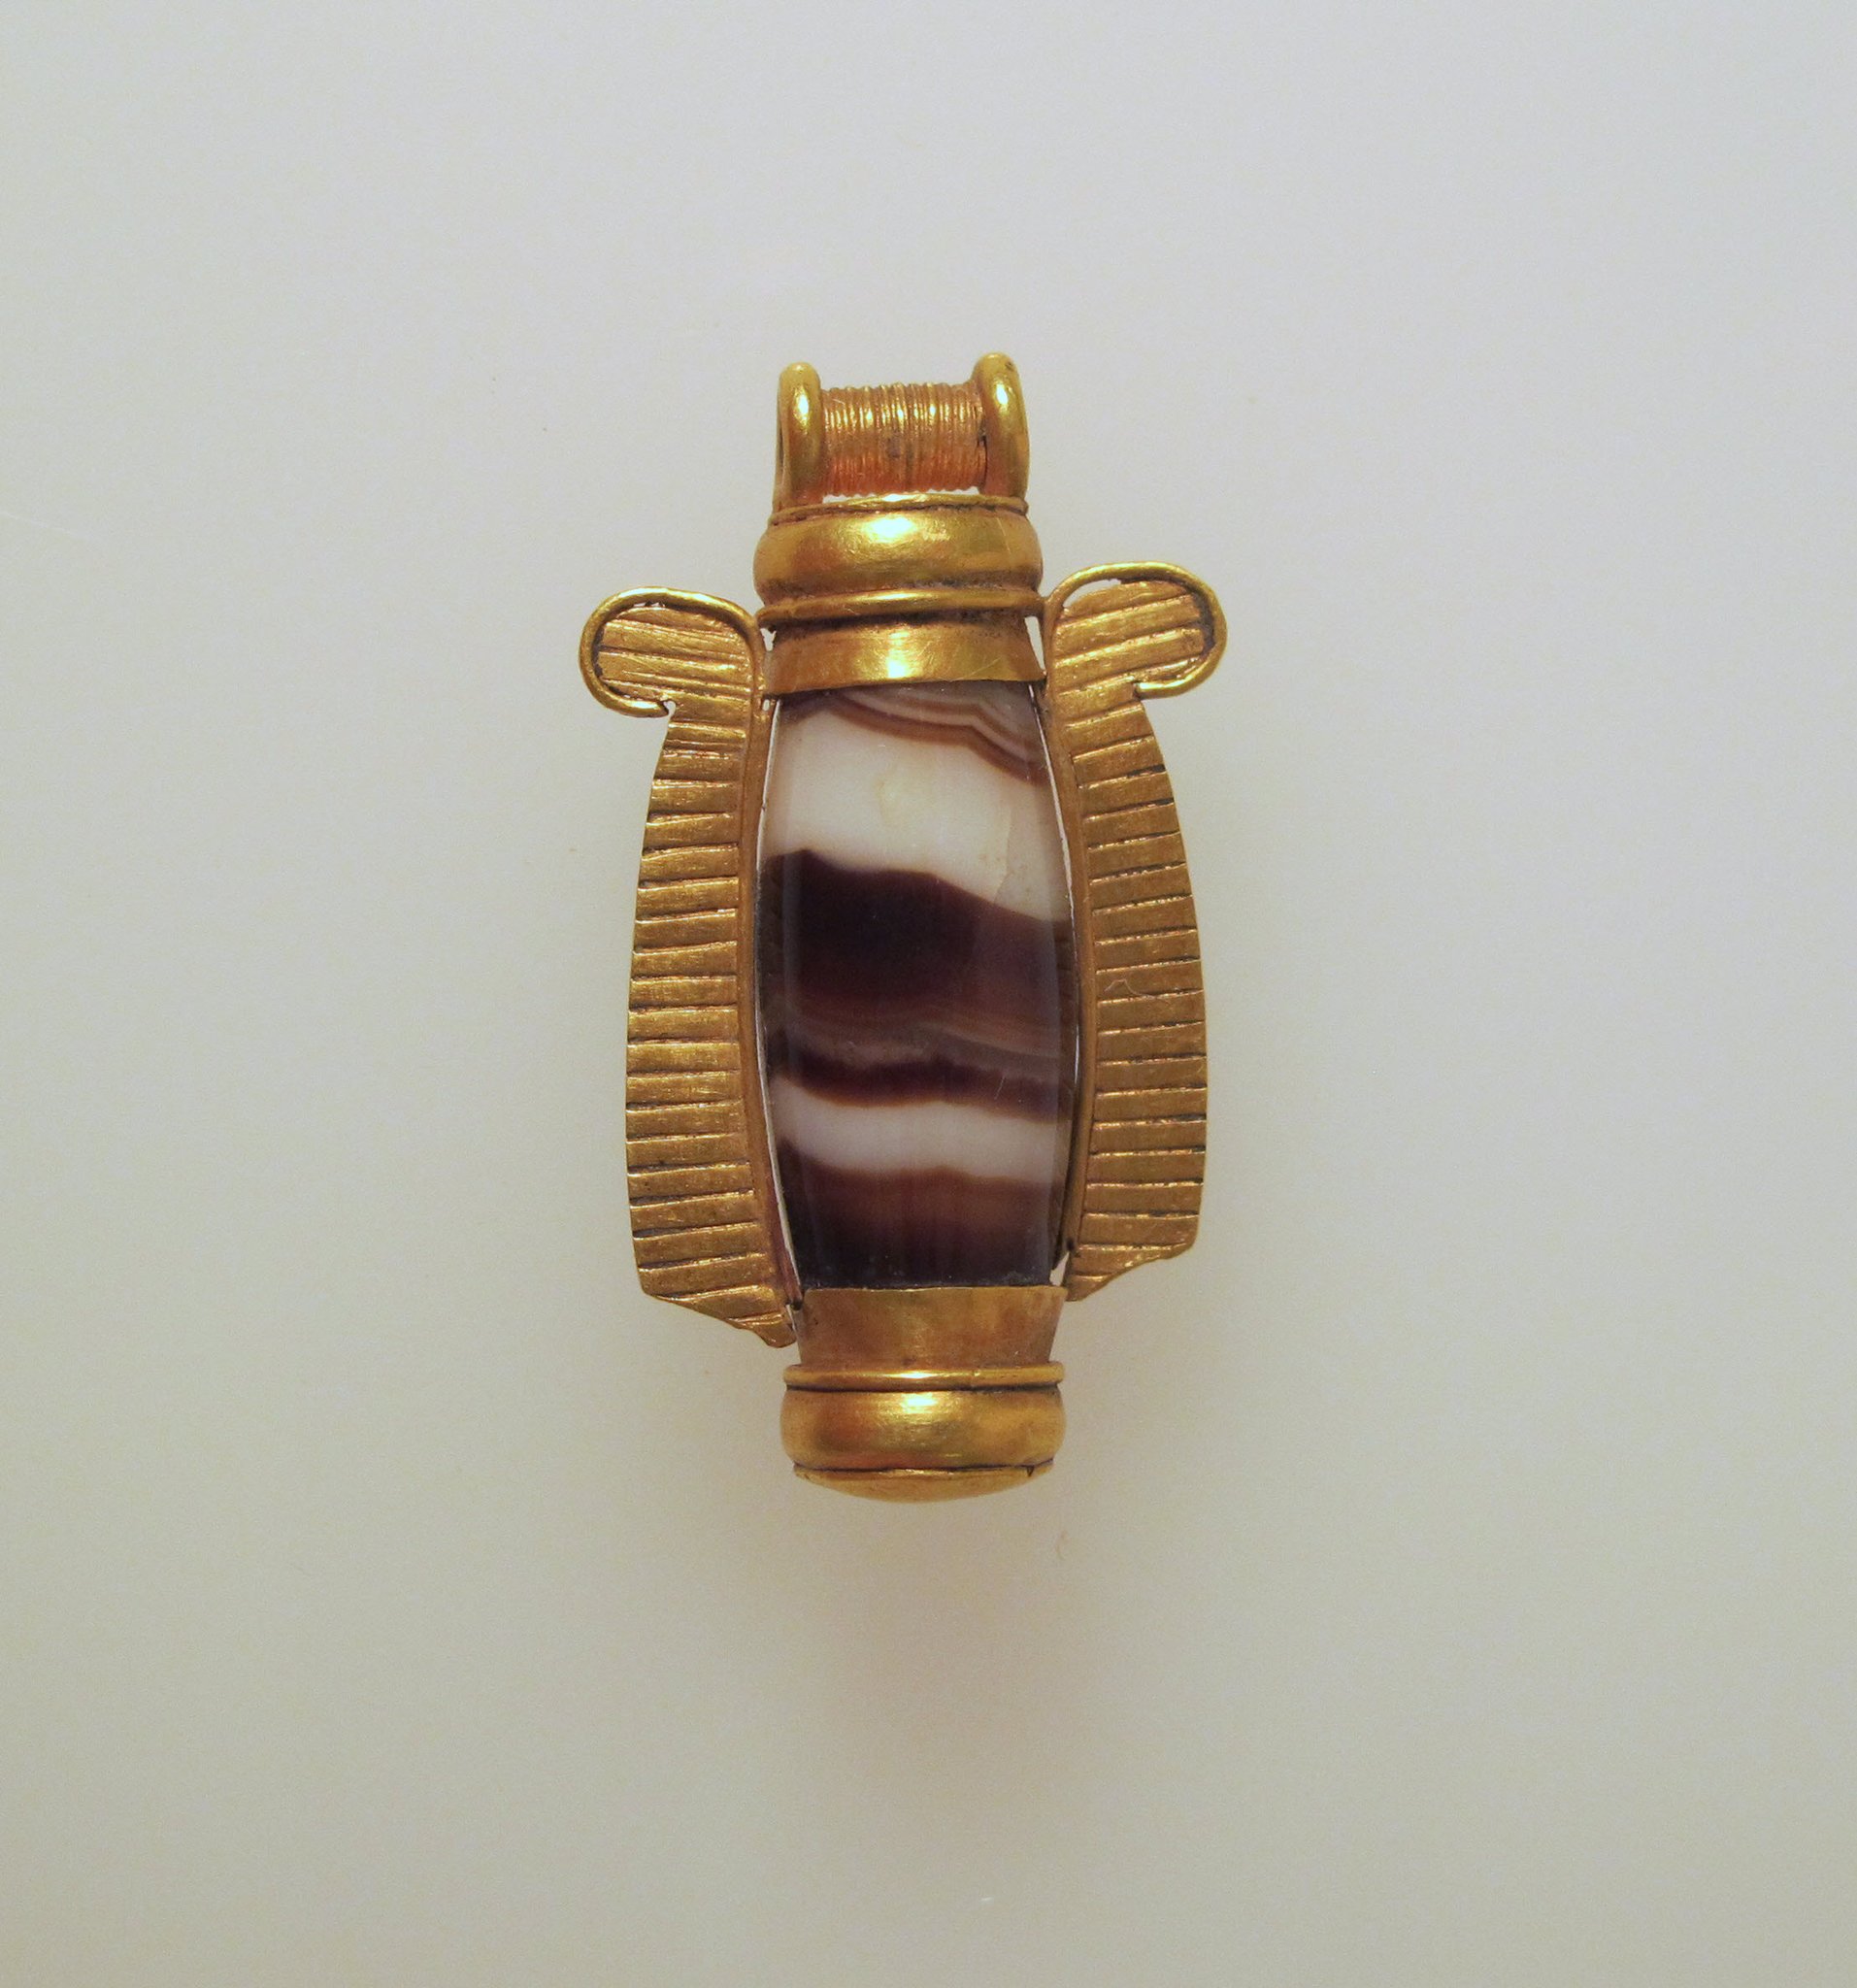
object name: pendant with agate bead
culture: cypriot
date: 3900 BCE-100 CE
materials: stone, gold